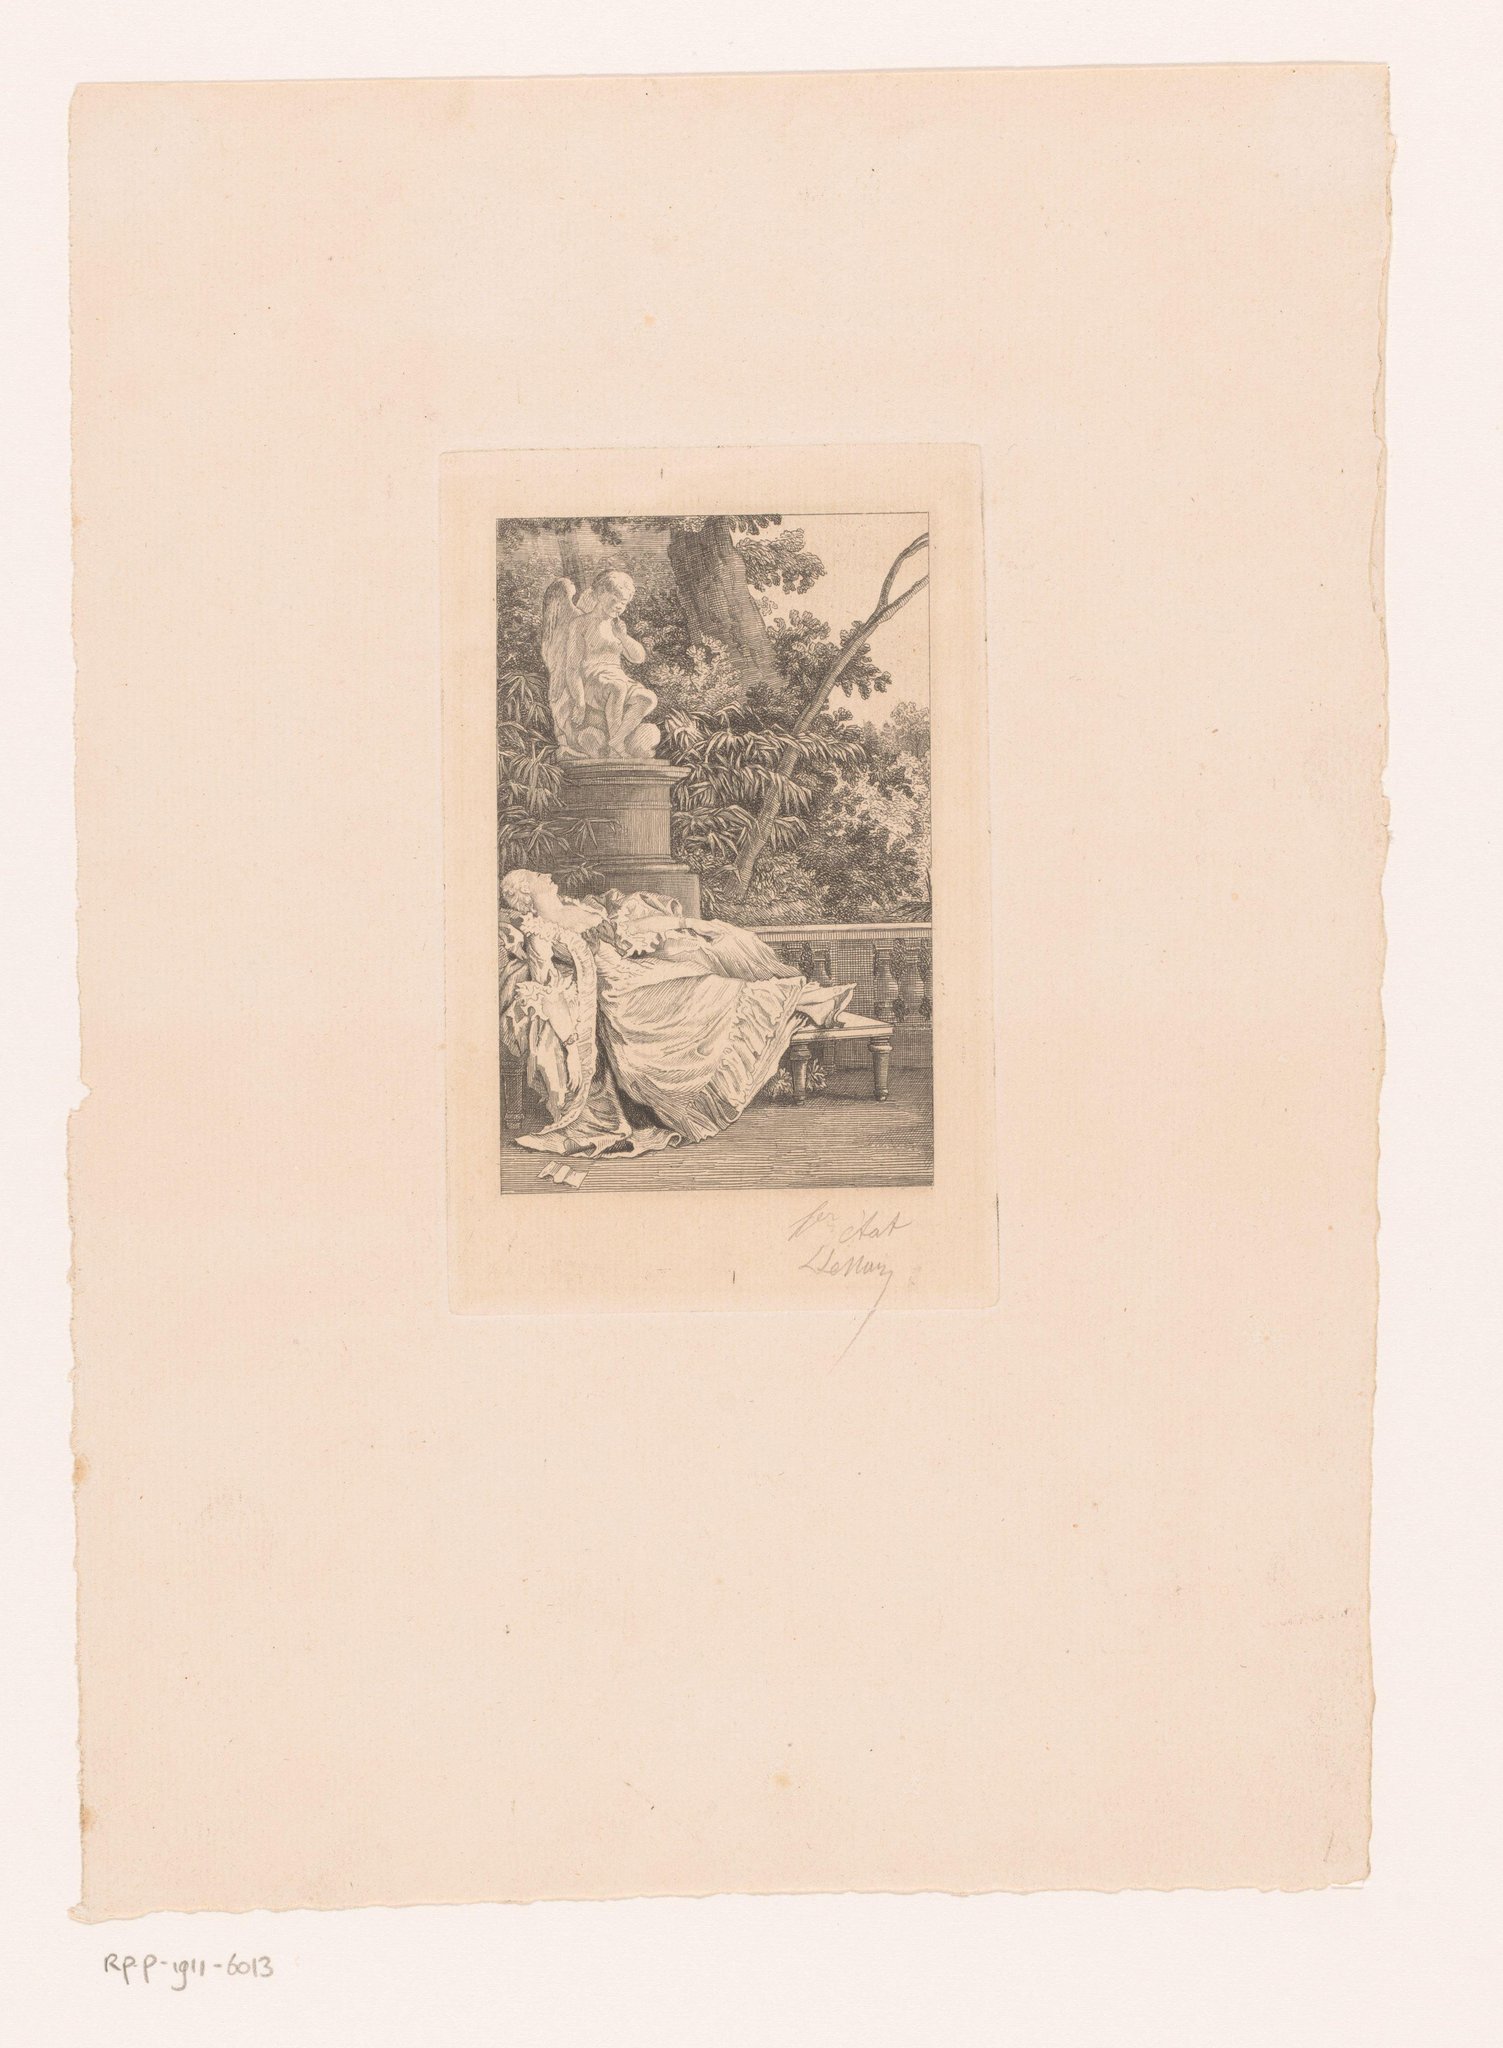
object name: print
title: Vrouw liggend op een bank in een tuin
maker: louis le nain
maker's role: print maker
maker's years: 1851-1939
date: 1861-1911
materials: paper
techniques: etching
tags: garden, lying figure - aa - female human figure, statues, sculptures in garden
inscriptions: inscription: ‘1er état LLeNain’, collector's mark: Lugt 2228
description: Links staat een tuinbeeld van Cupido met zijn vinger voor zijn mond. Dit beeld en het briefje op de grond naast de vrouw, verwijzen naar een mogelijke (geheime) liefde van de vrouw.